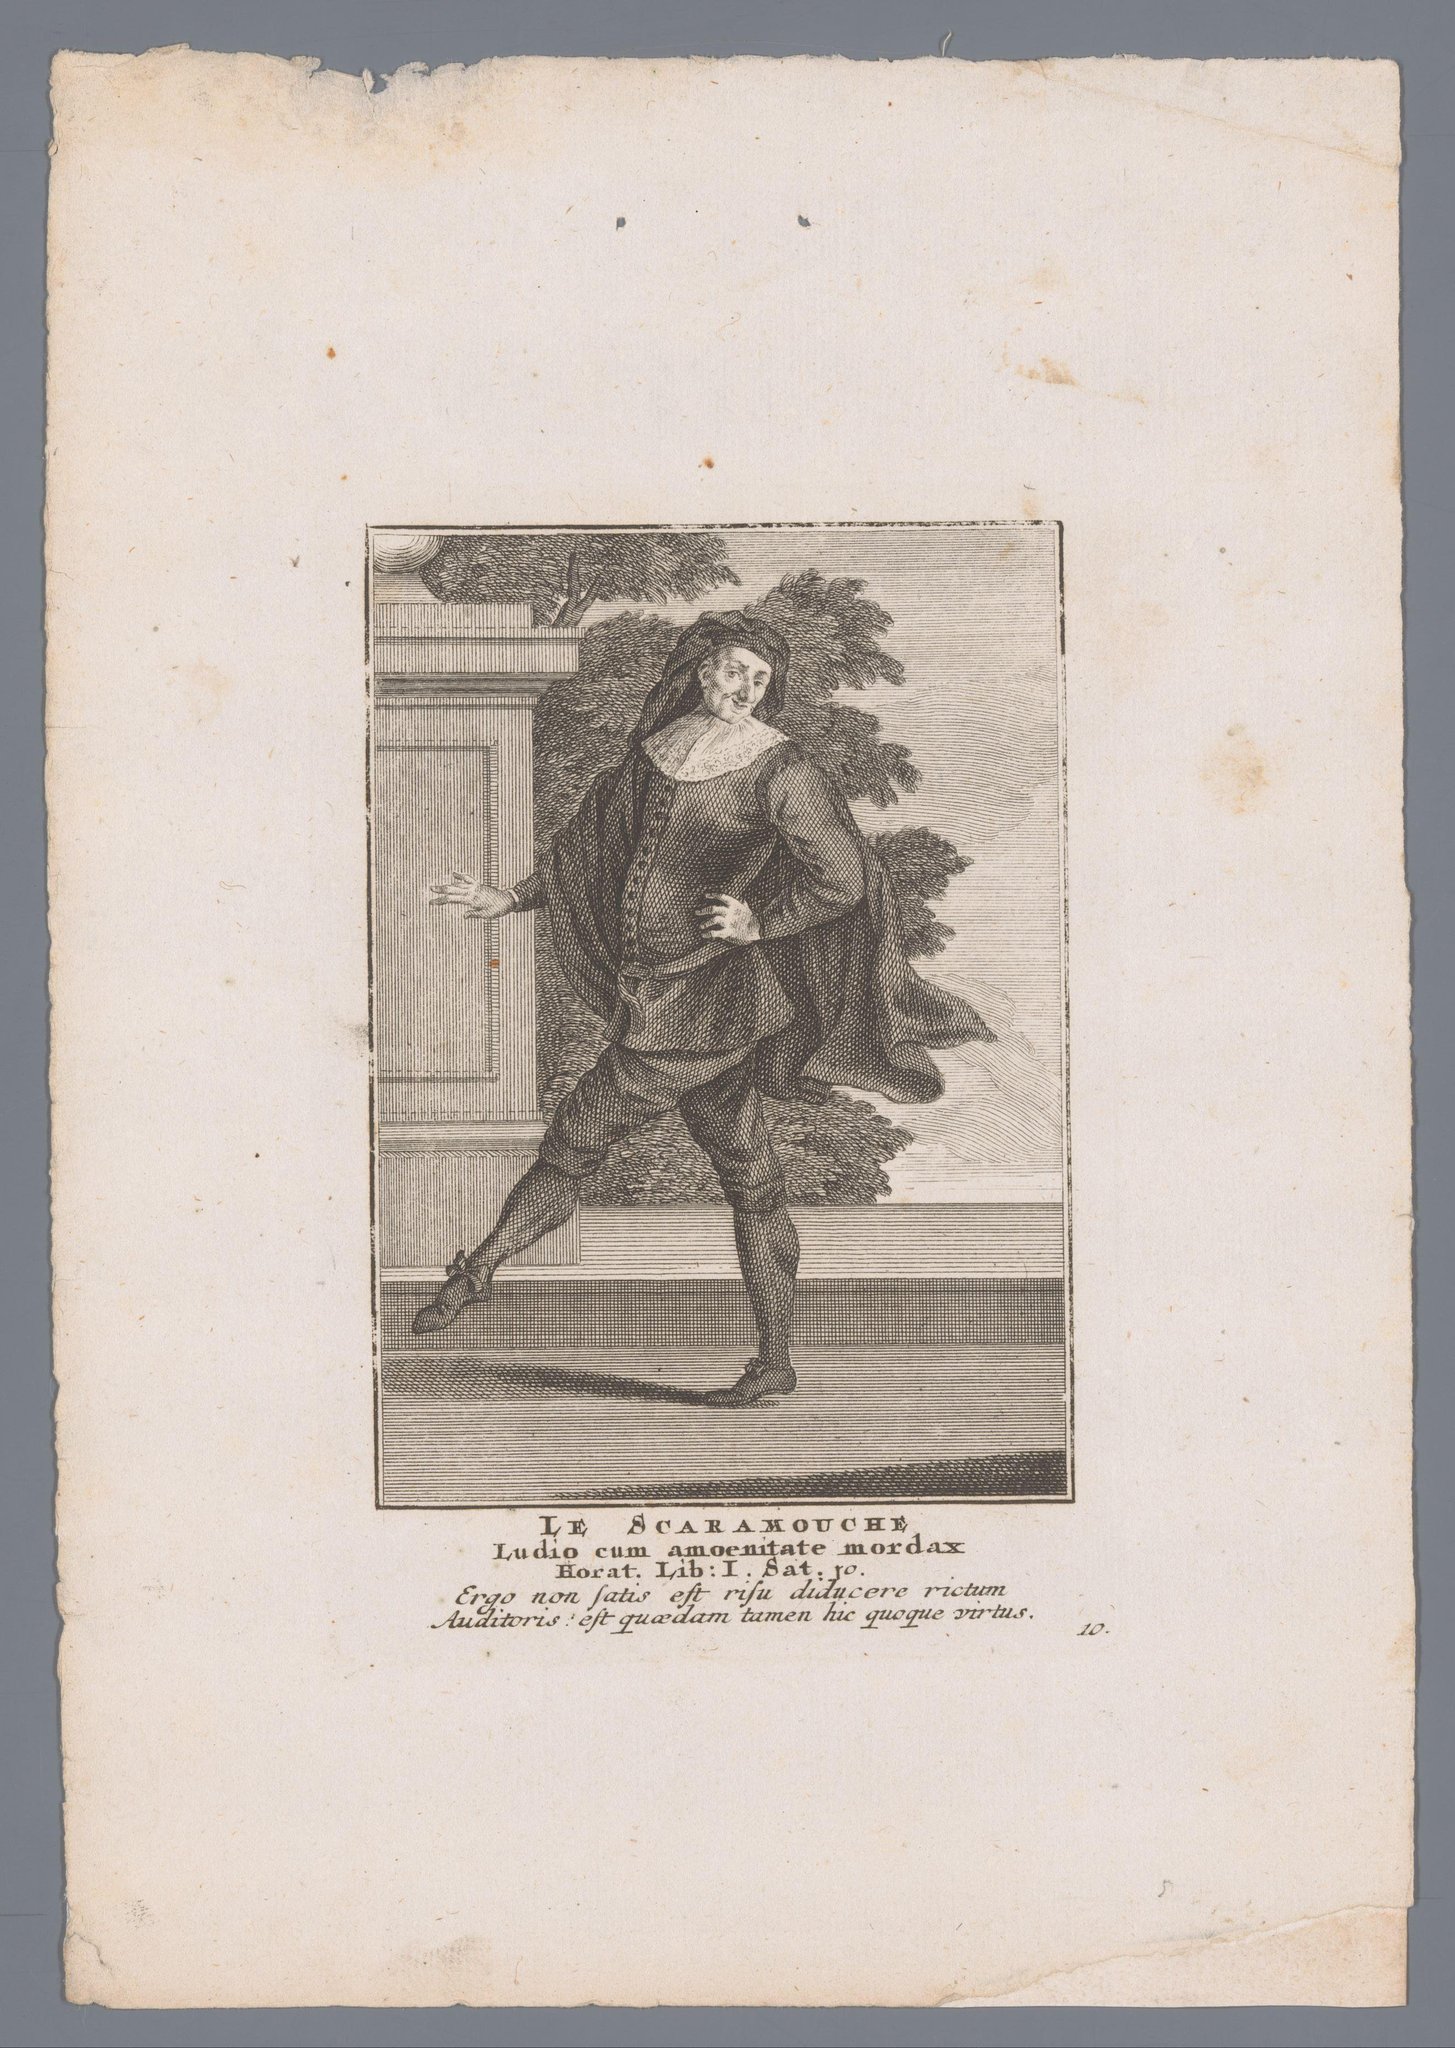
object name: print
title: Personages uit de Commedia dell'arte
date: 1694-1725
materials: paper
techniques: etching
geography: germany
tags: types in 'commedia dell'arte', group of actors, troupe; actors on the stage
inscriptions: collector's mark: Lugt 2228